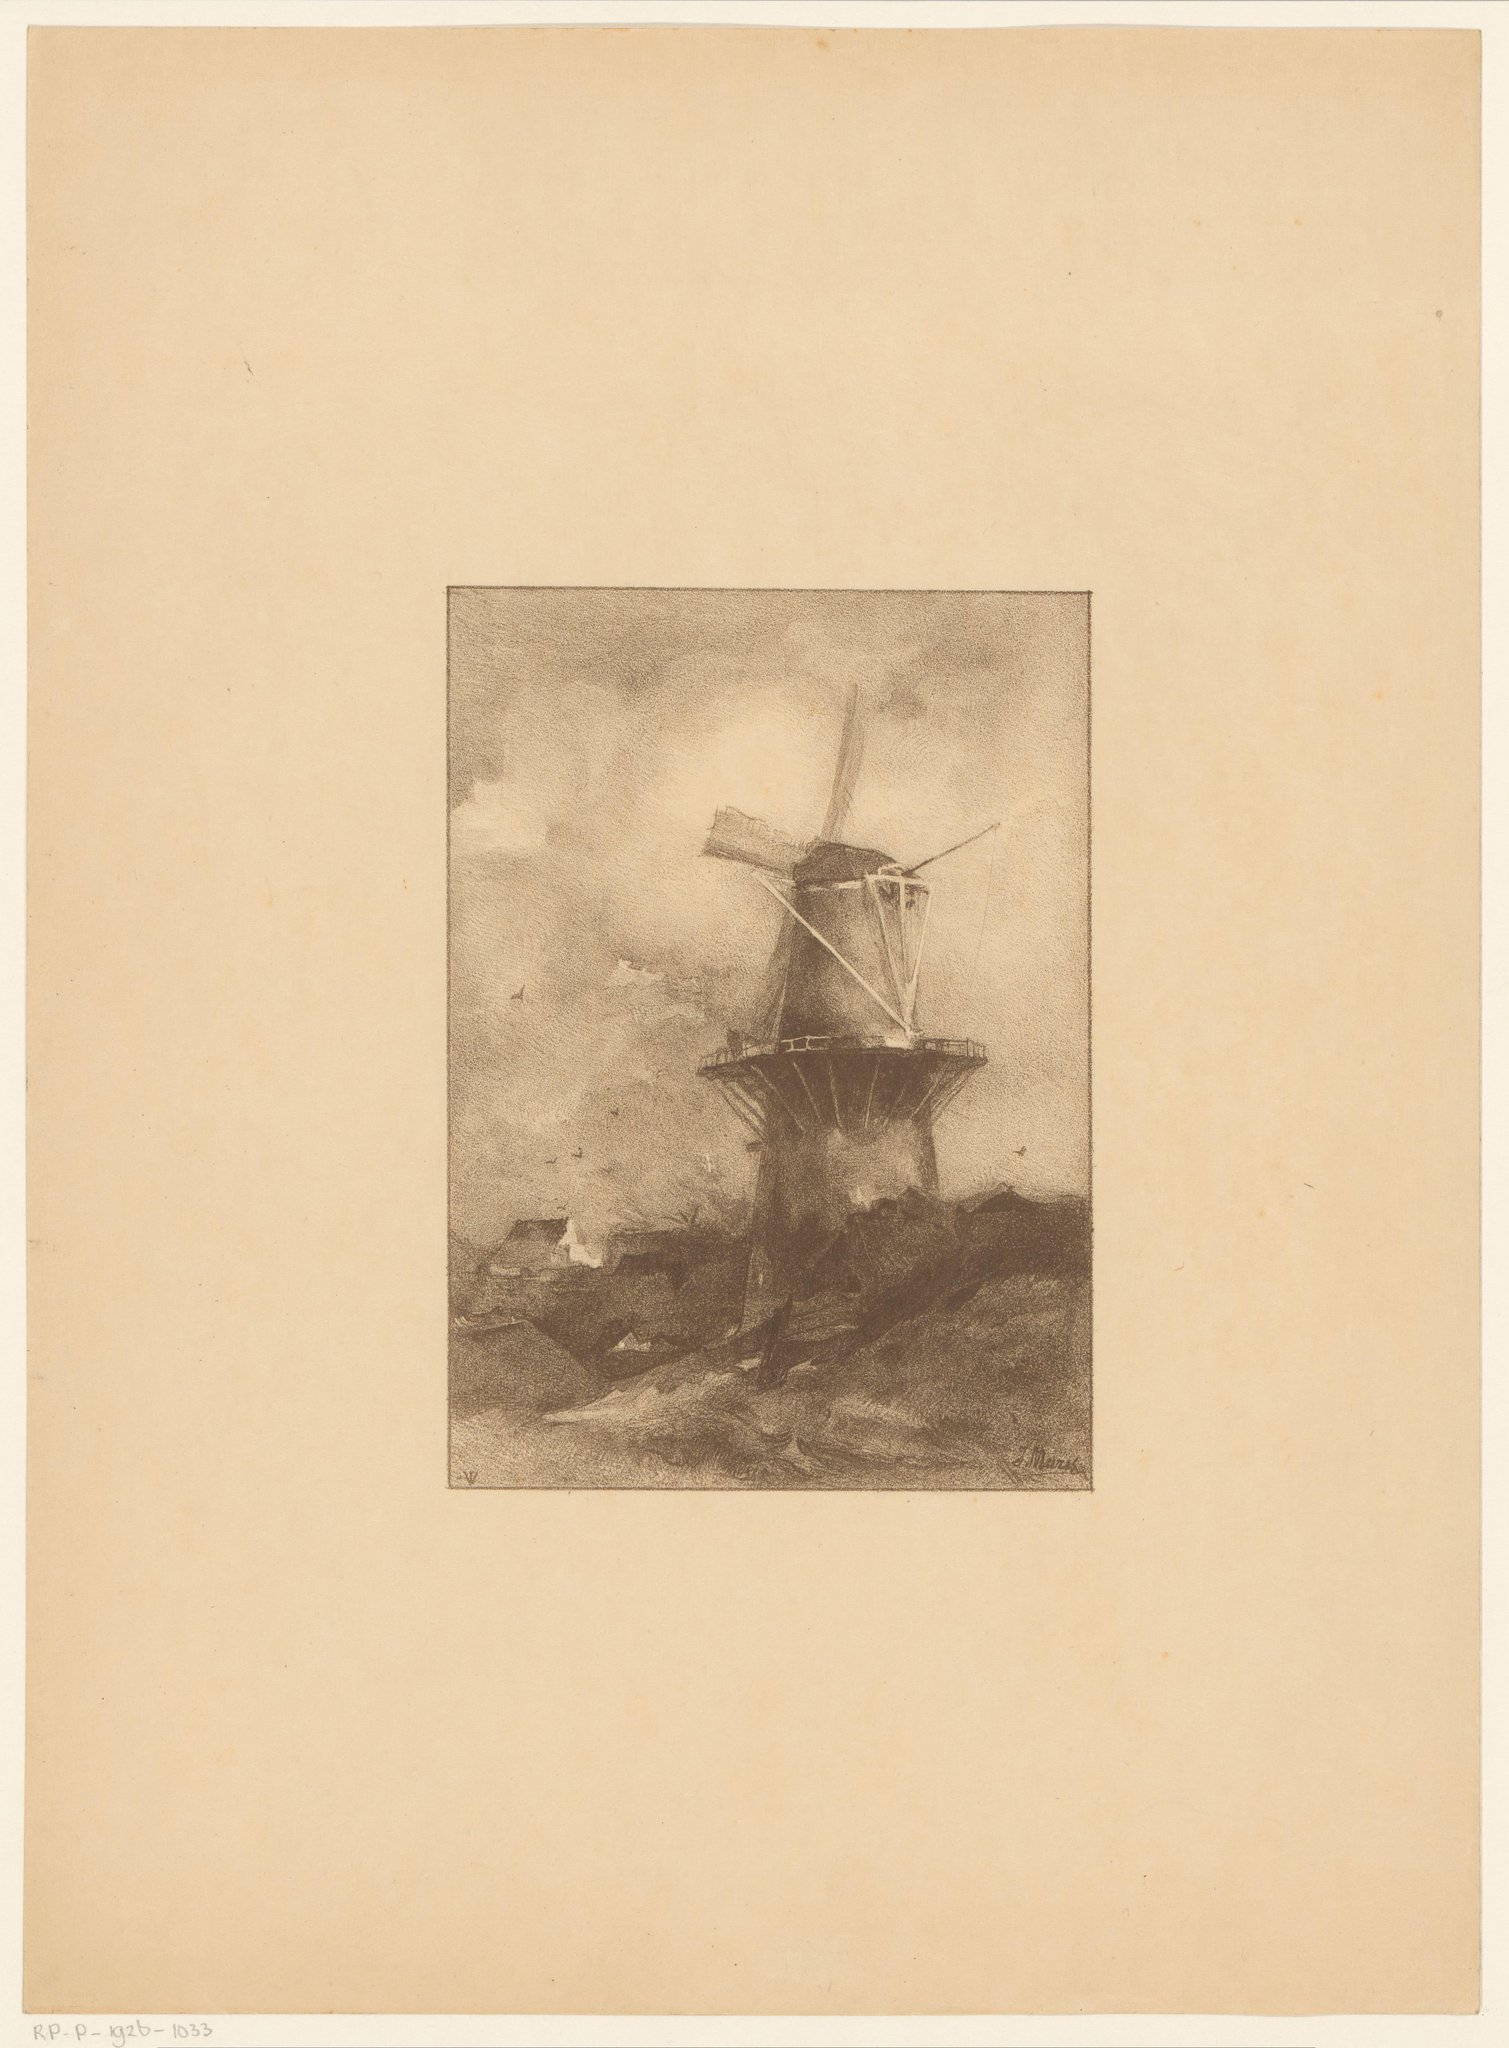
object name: print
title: Molen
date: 1880-1900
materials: paper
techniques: lithograph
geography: netherlands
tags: windmill in landscape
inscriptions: collector's mark: Lugt 2228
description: Een stenen molen in een landschap met huizen in de achtergrond.